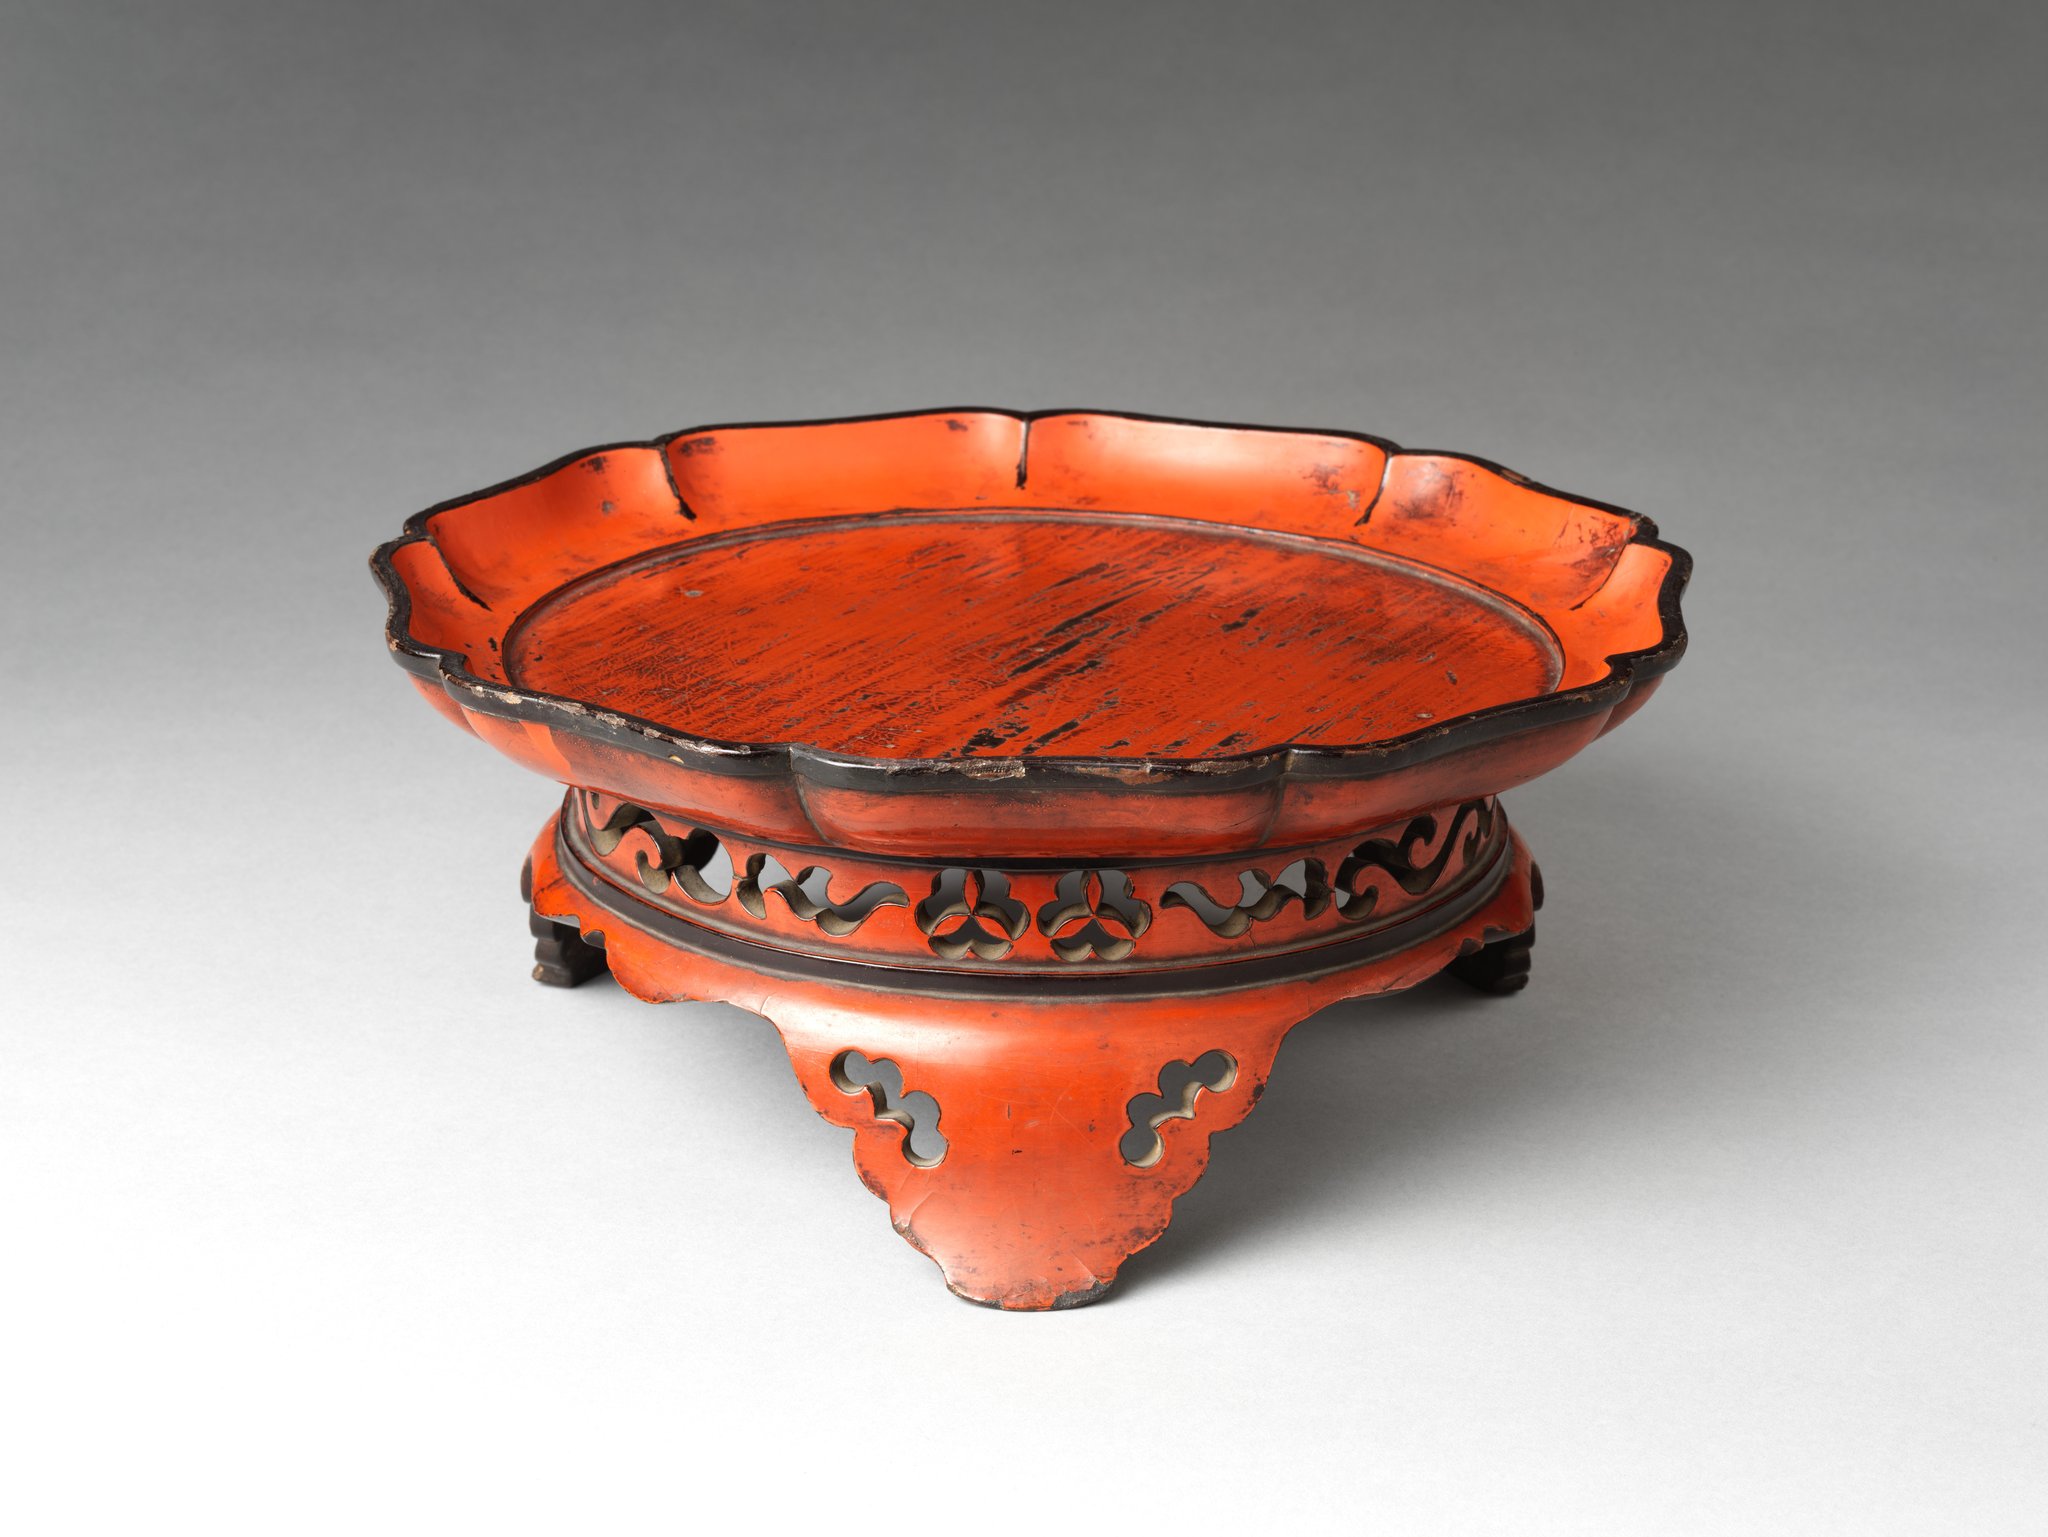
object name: tray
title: Flower-shaped Negoro Tray (Kōban) with Three Feet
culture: japanese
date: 1401-1500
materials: lacquer, wood